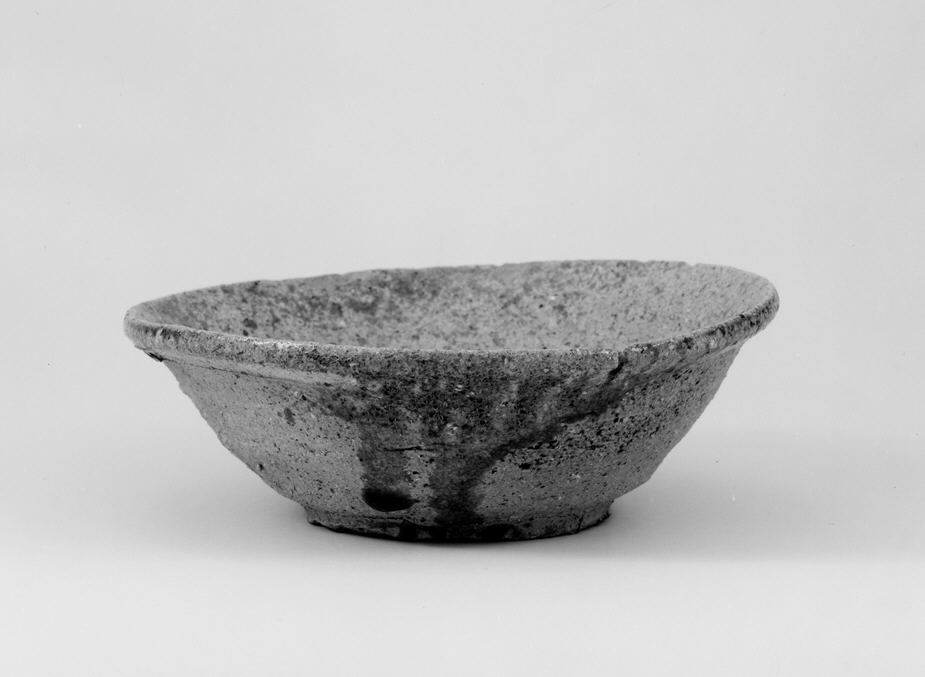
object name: bowl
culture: japanese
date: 1201-1300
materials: wood, glaze, stoneware